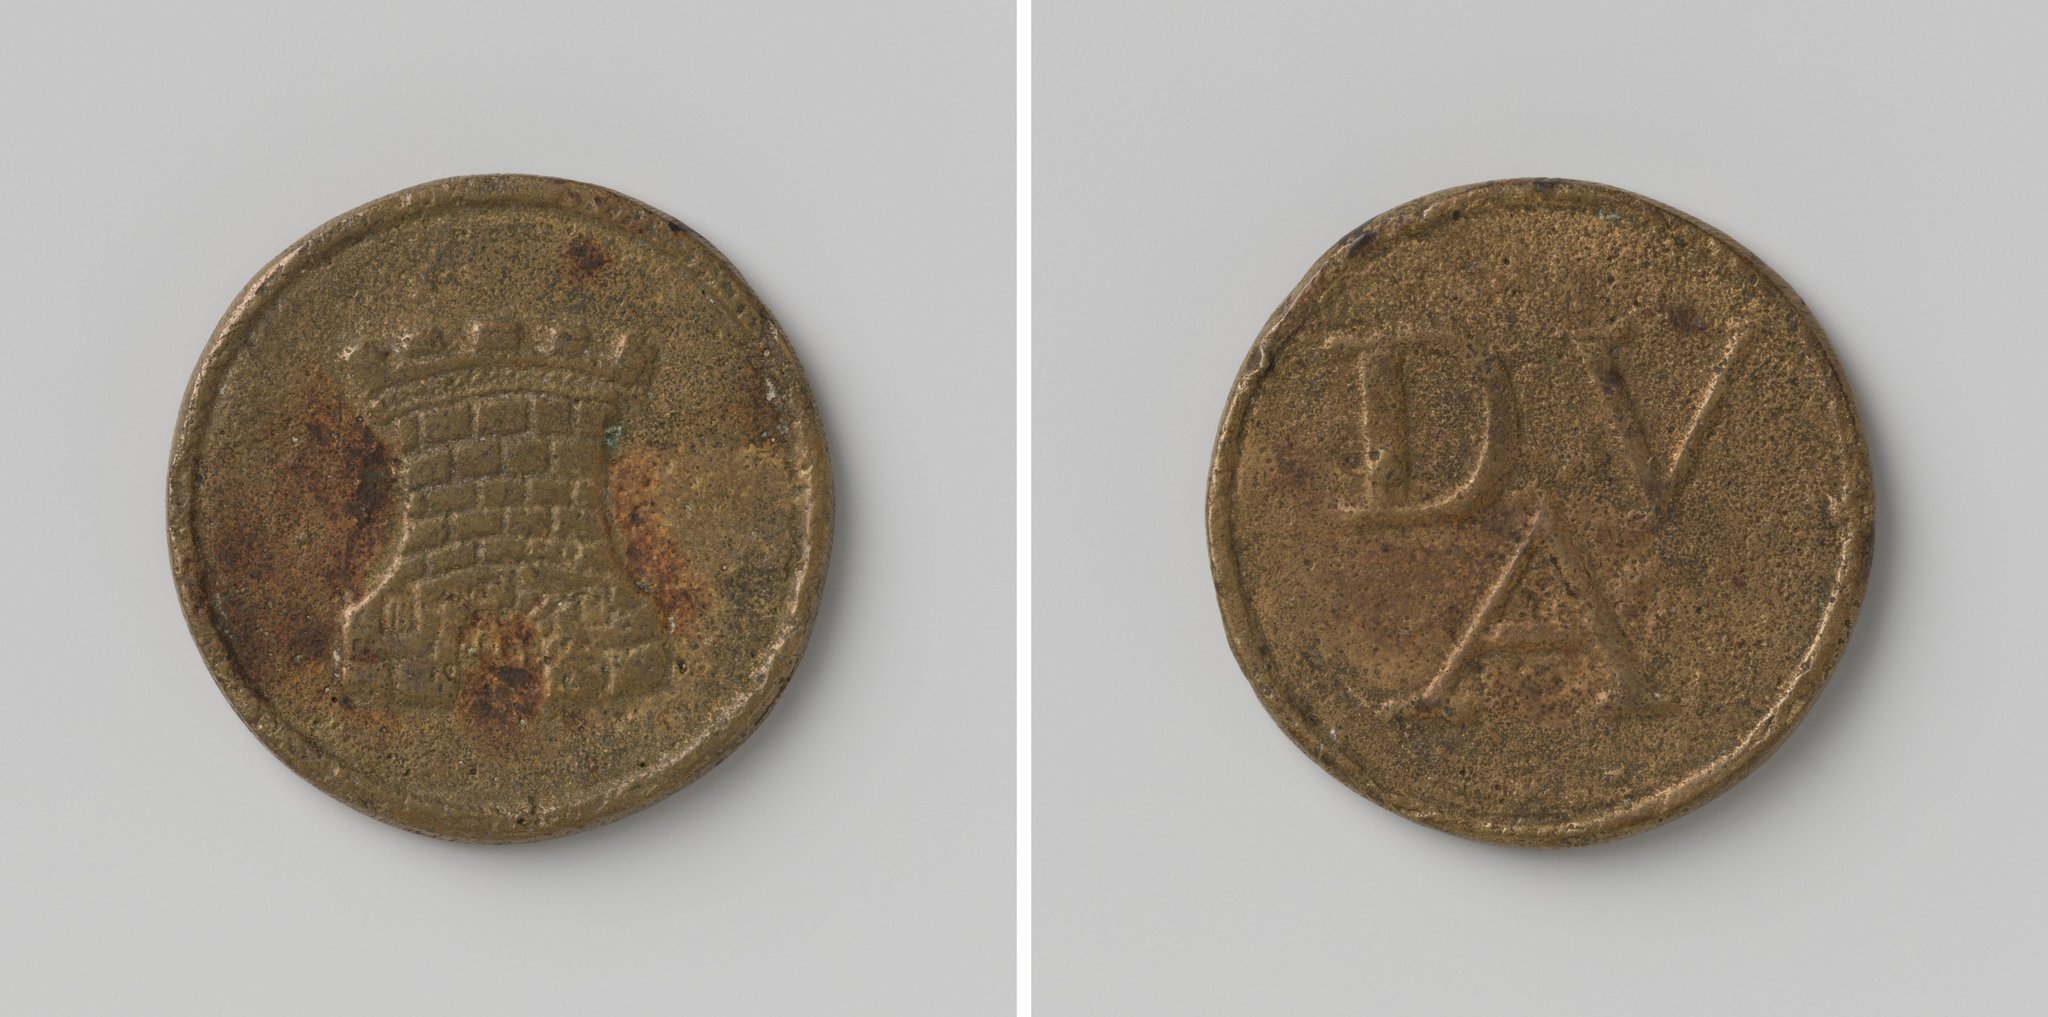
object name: armenloodje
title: Diaconie van Alkmaar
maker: Anonymous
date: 1600-1800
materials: brass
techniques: casting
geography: alkmaar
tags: alkmaar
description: Messing penning. Voorzijde: burcht. Keerzijde: letters D en V, boven letter A.